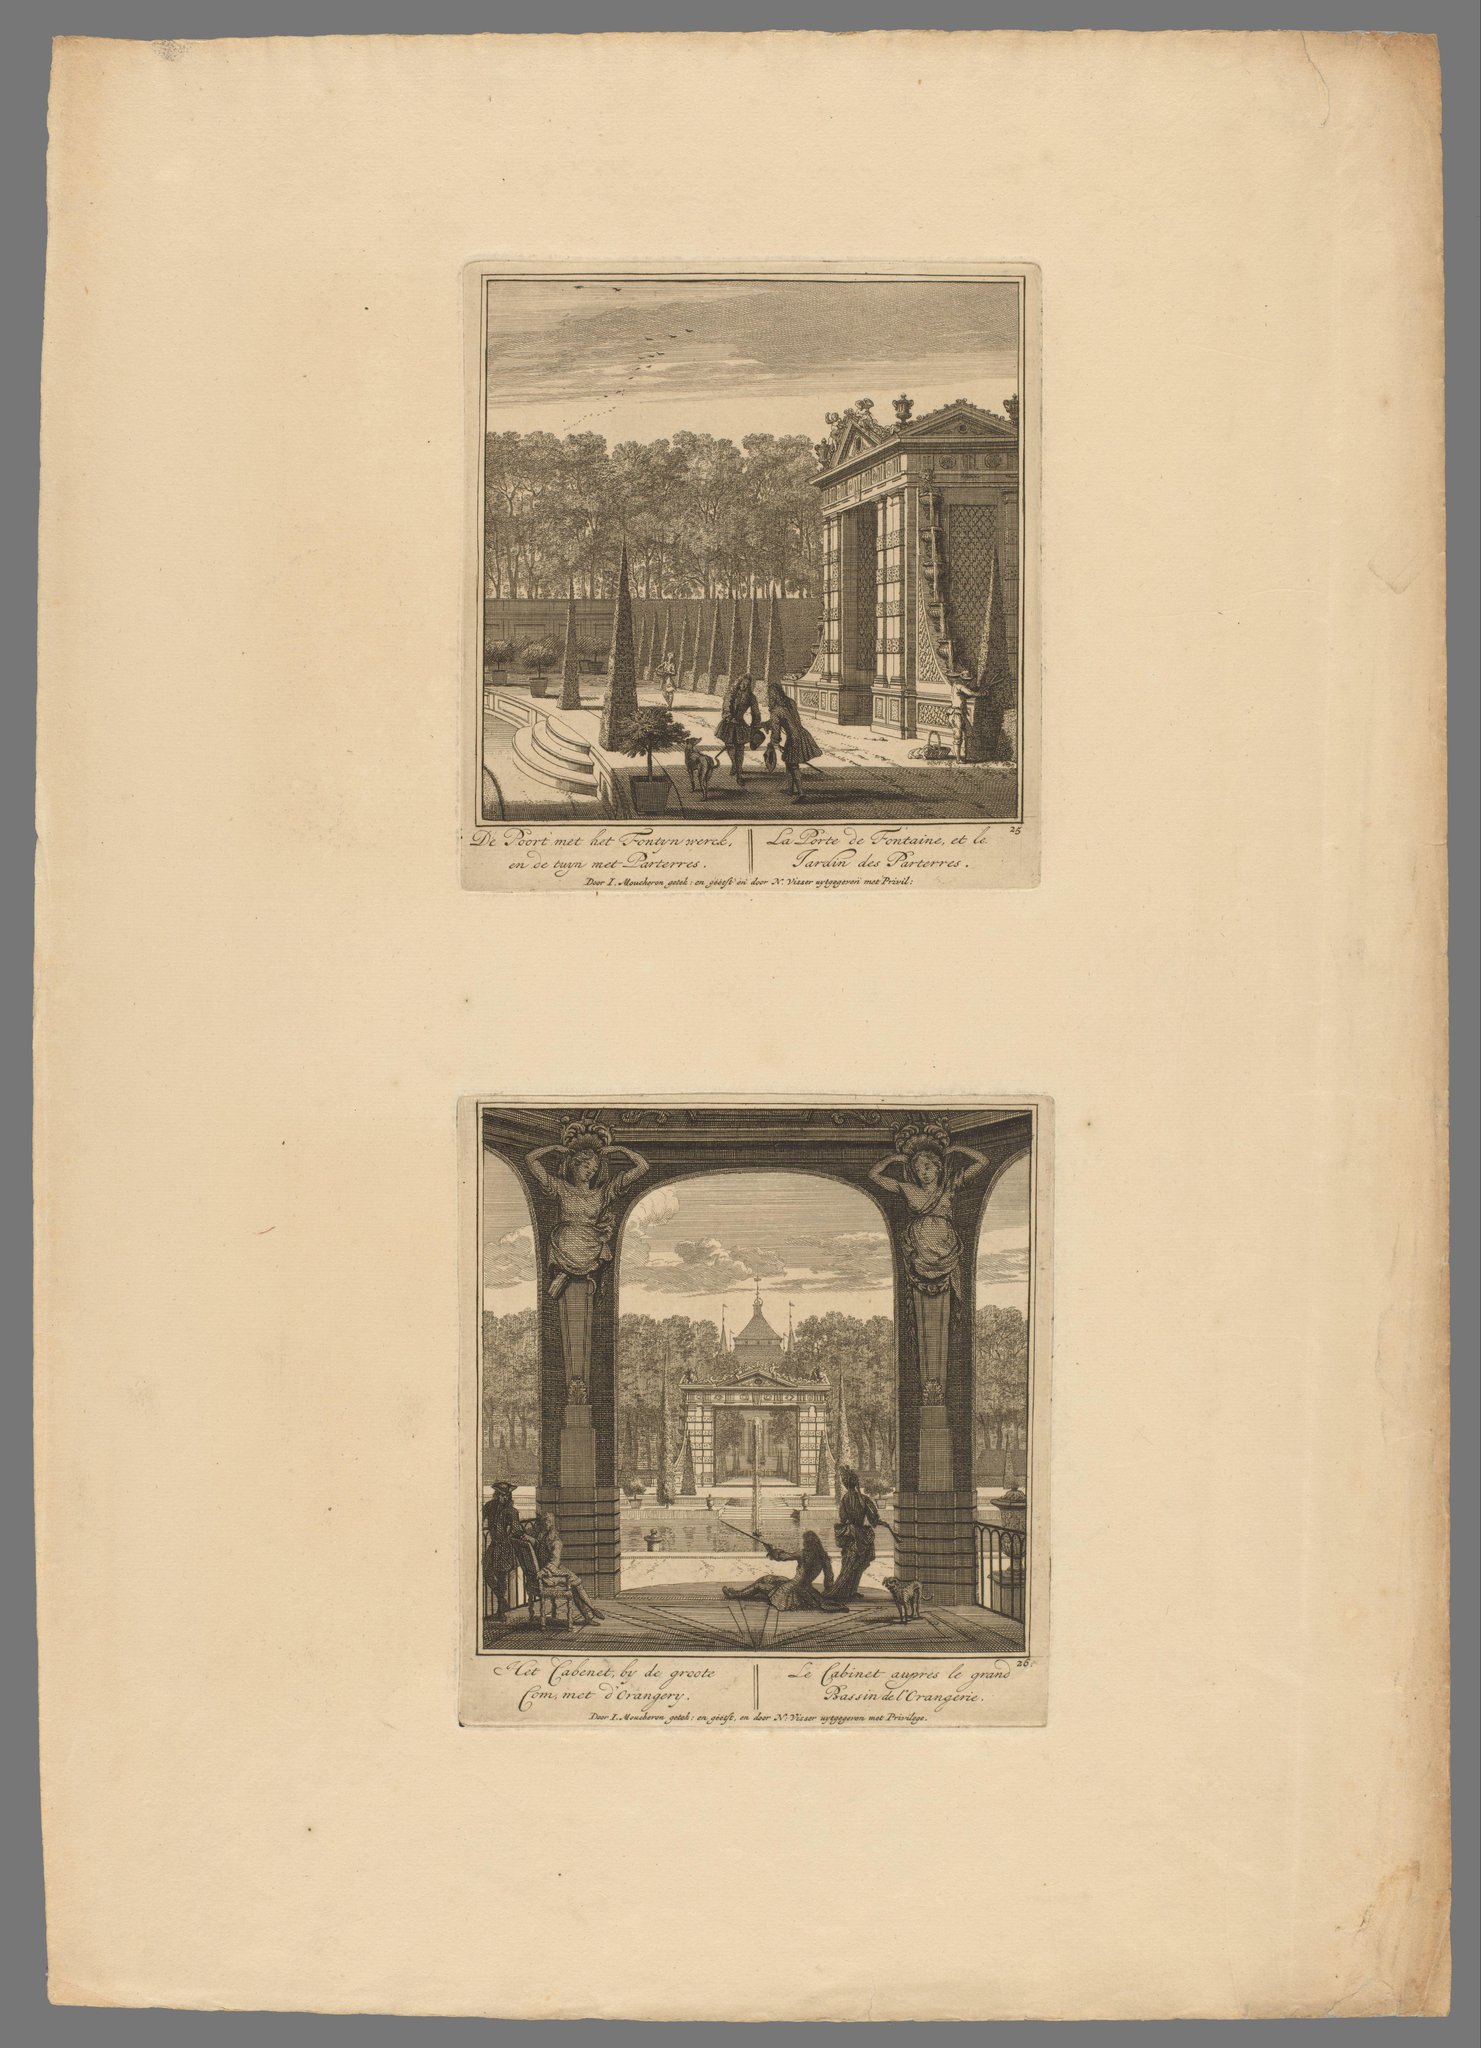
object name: print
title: De Poort met het Fontyn werck, en de tuyn met parterres / Het Cabenet, by de groote Com, met d'Orangery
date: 1706-1719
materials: paper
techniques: engraving, etching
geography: amsterdam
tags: castle, garden buildings, garden pond, dog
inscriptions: collector's mark: Lugt 2228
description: Twee voorstellingen. Boven: de poort in de tuin van Kasteel Heemstede van opzij gezien. In de poort zijn fonteinen verwerkt. Op de voorgrond twee mannen met een hond. Onder: vanuit een prieel, waarin drie mannen, een vrouw en een hond zich verpozen, zicht op de grote vijver, de poort en geheel achteraan Kasteel Heemstede.